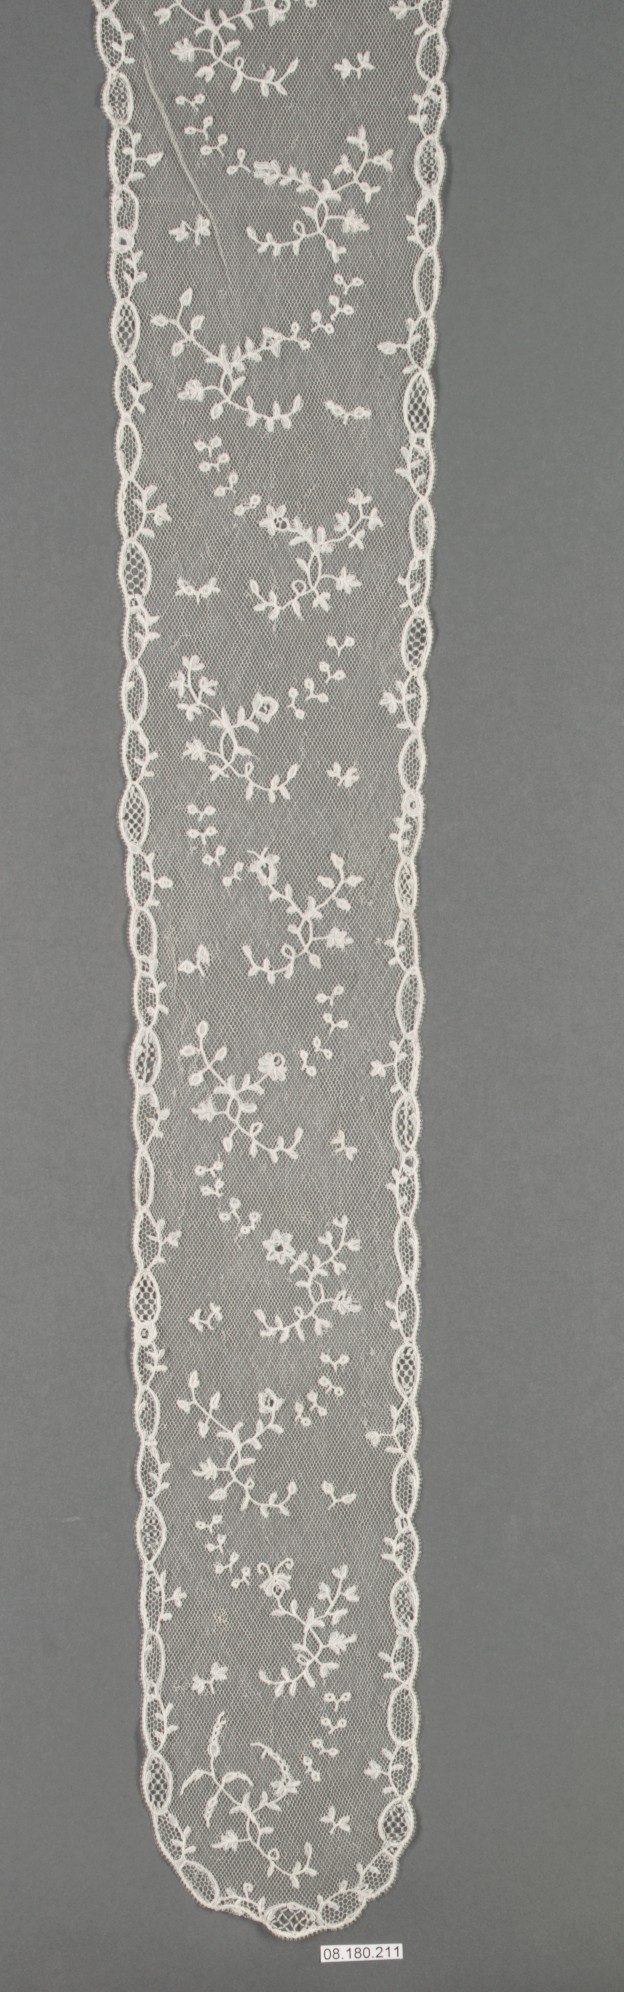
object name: barbe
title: Barbe (one end)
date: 1767-1800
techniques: lace